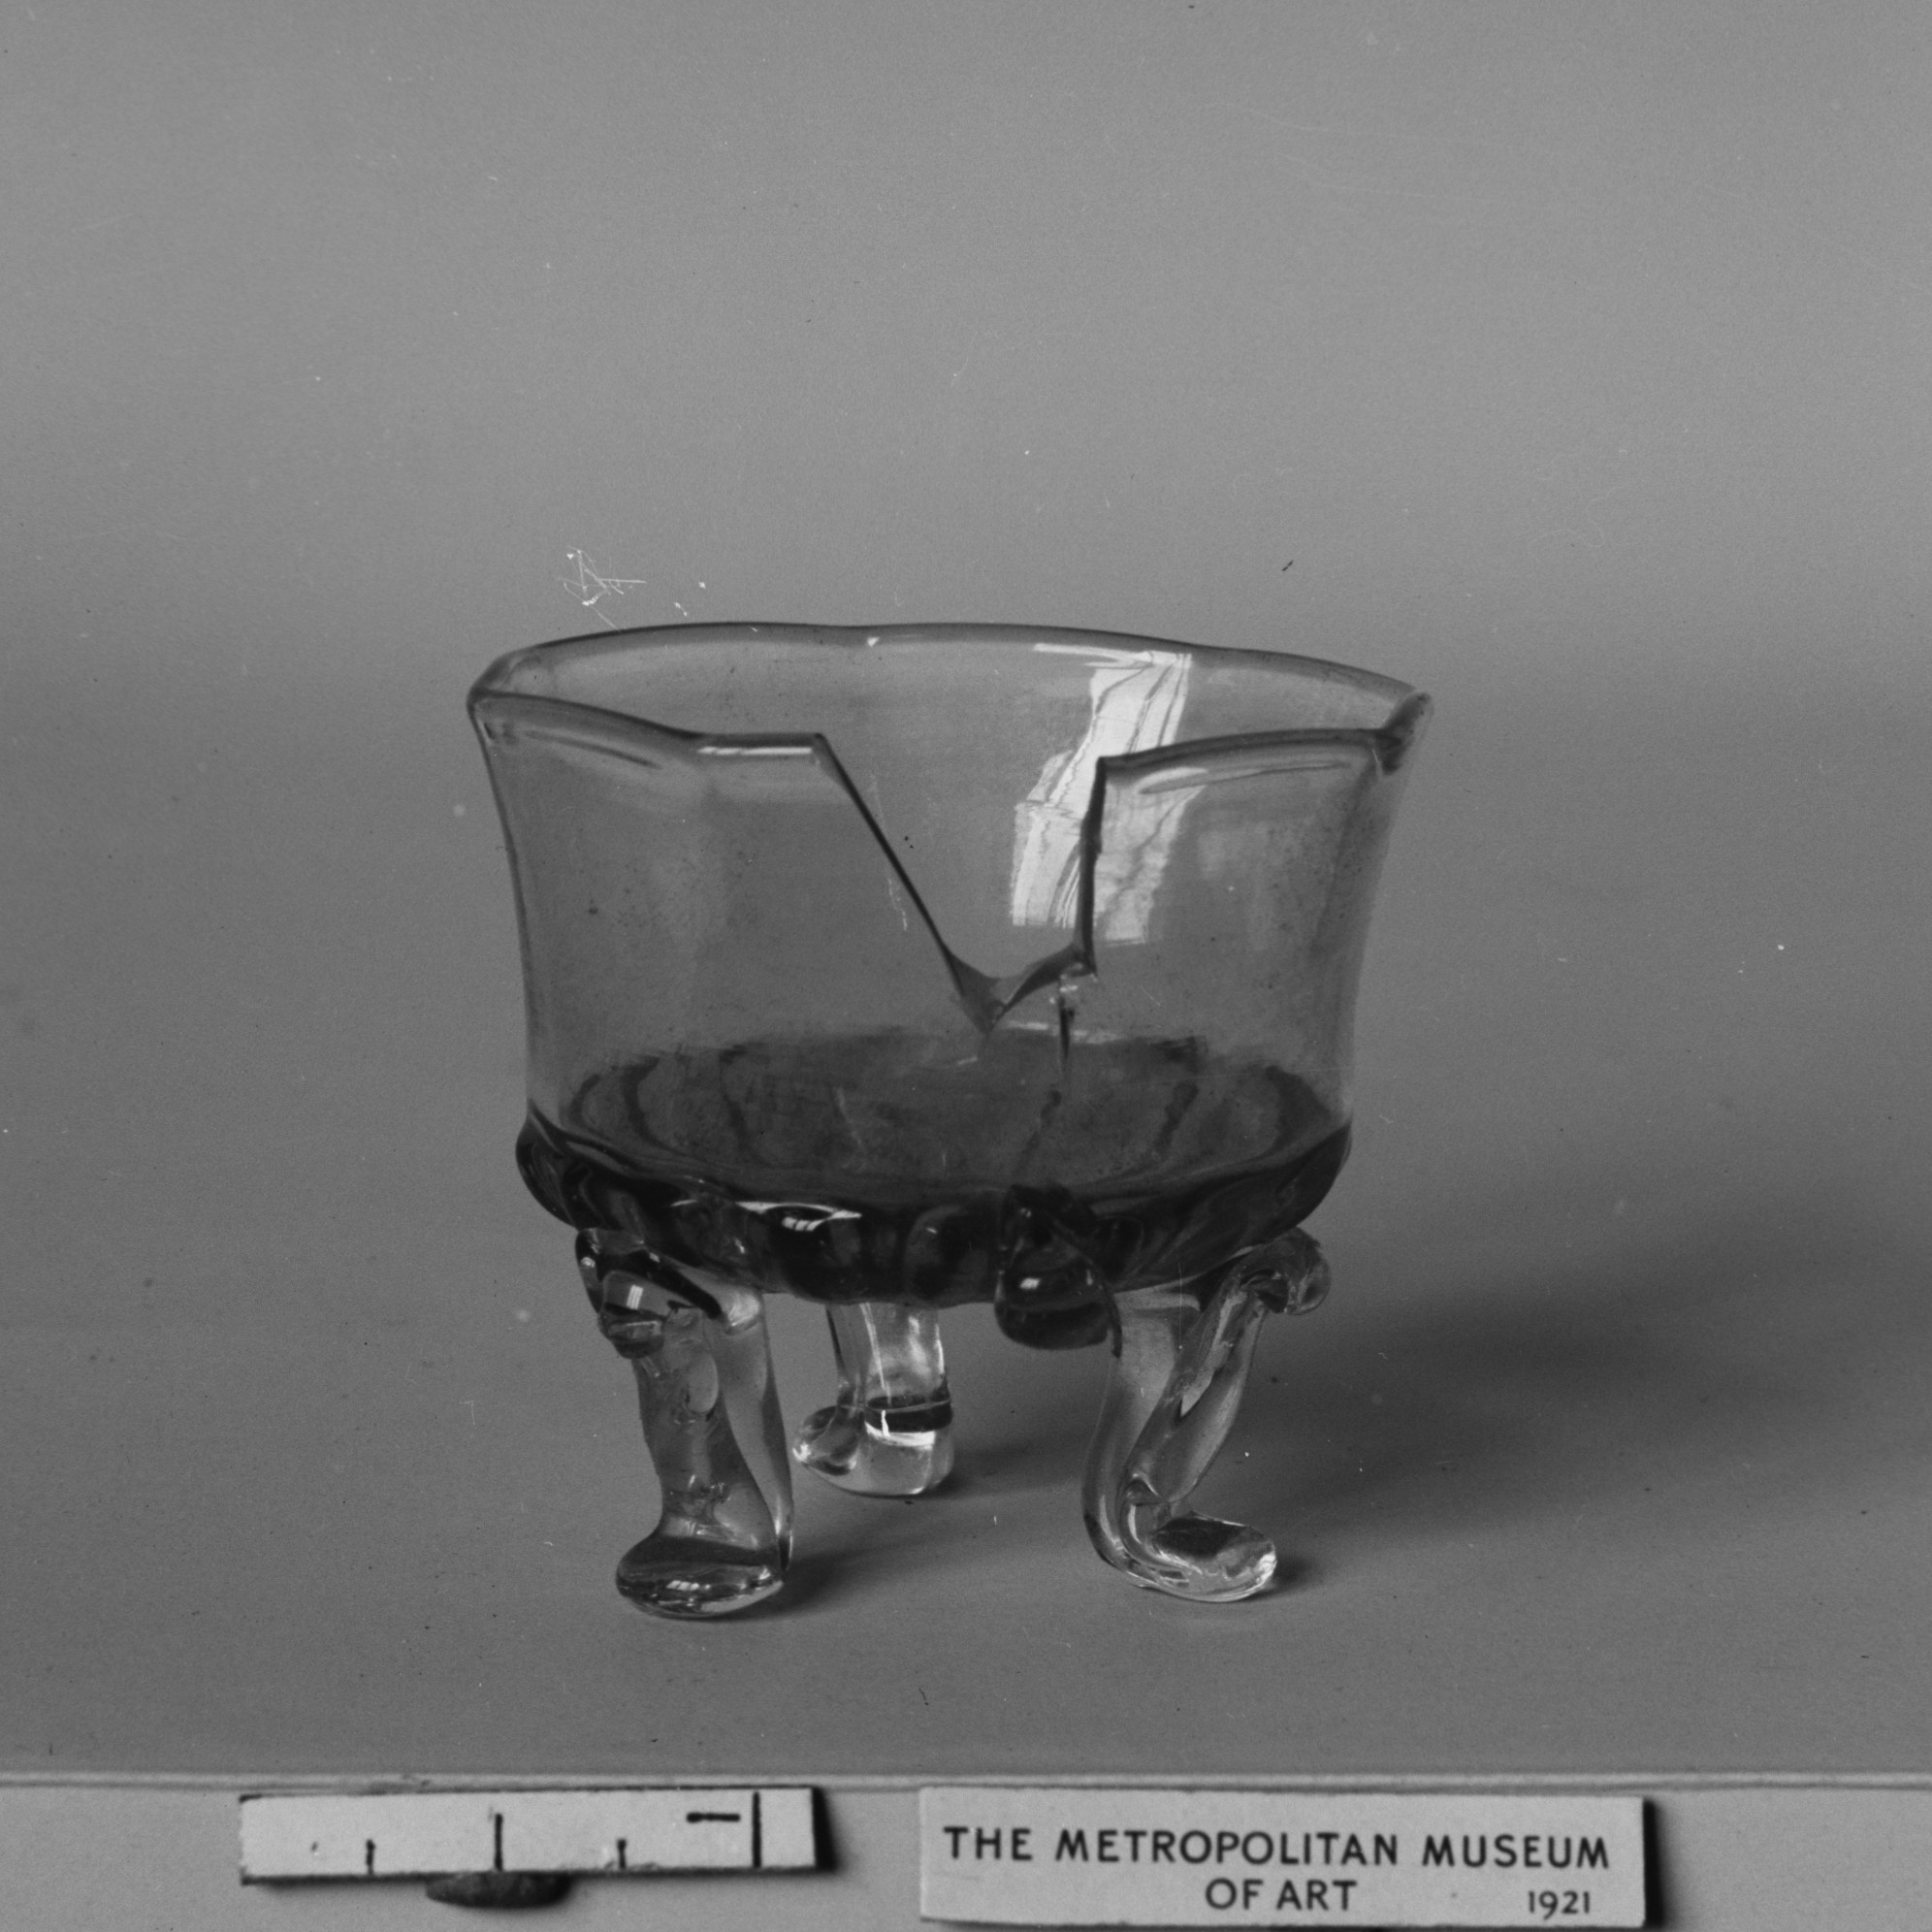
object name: saltcellar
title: Saltcellar (?)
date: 1701-1900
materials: glass